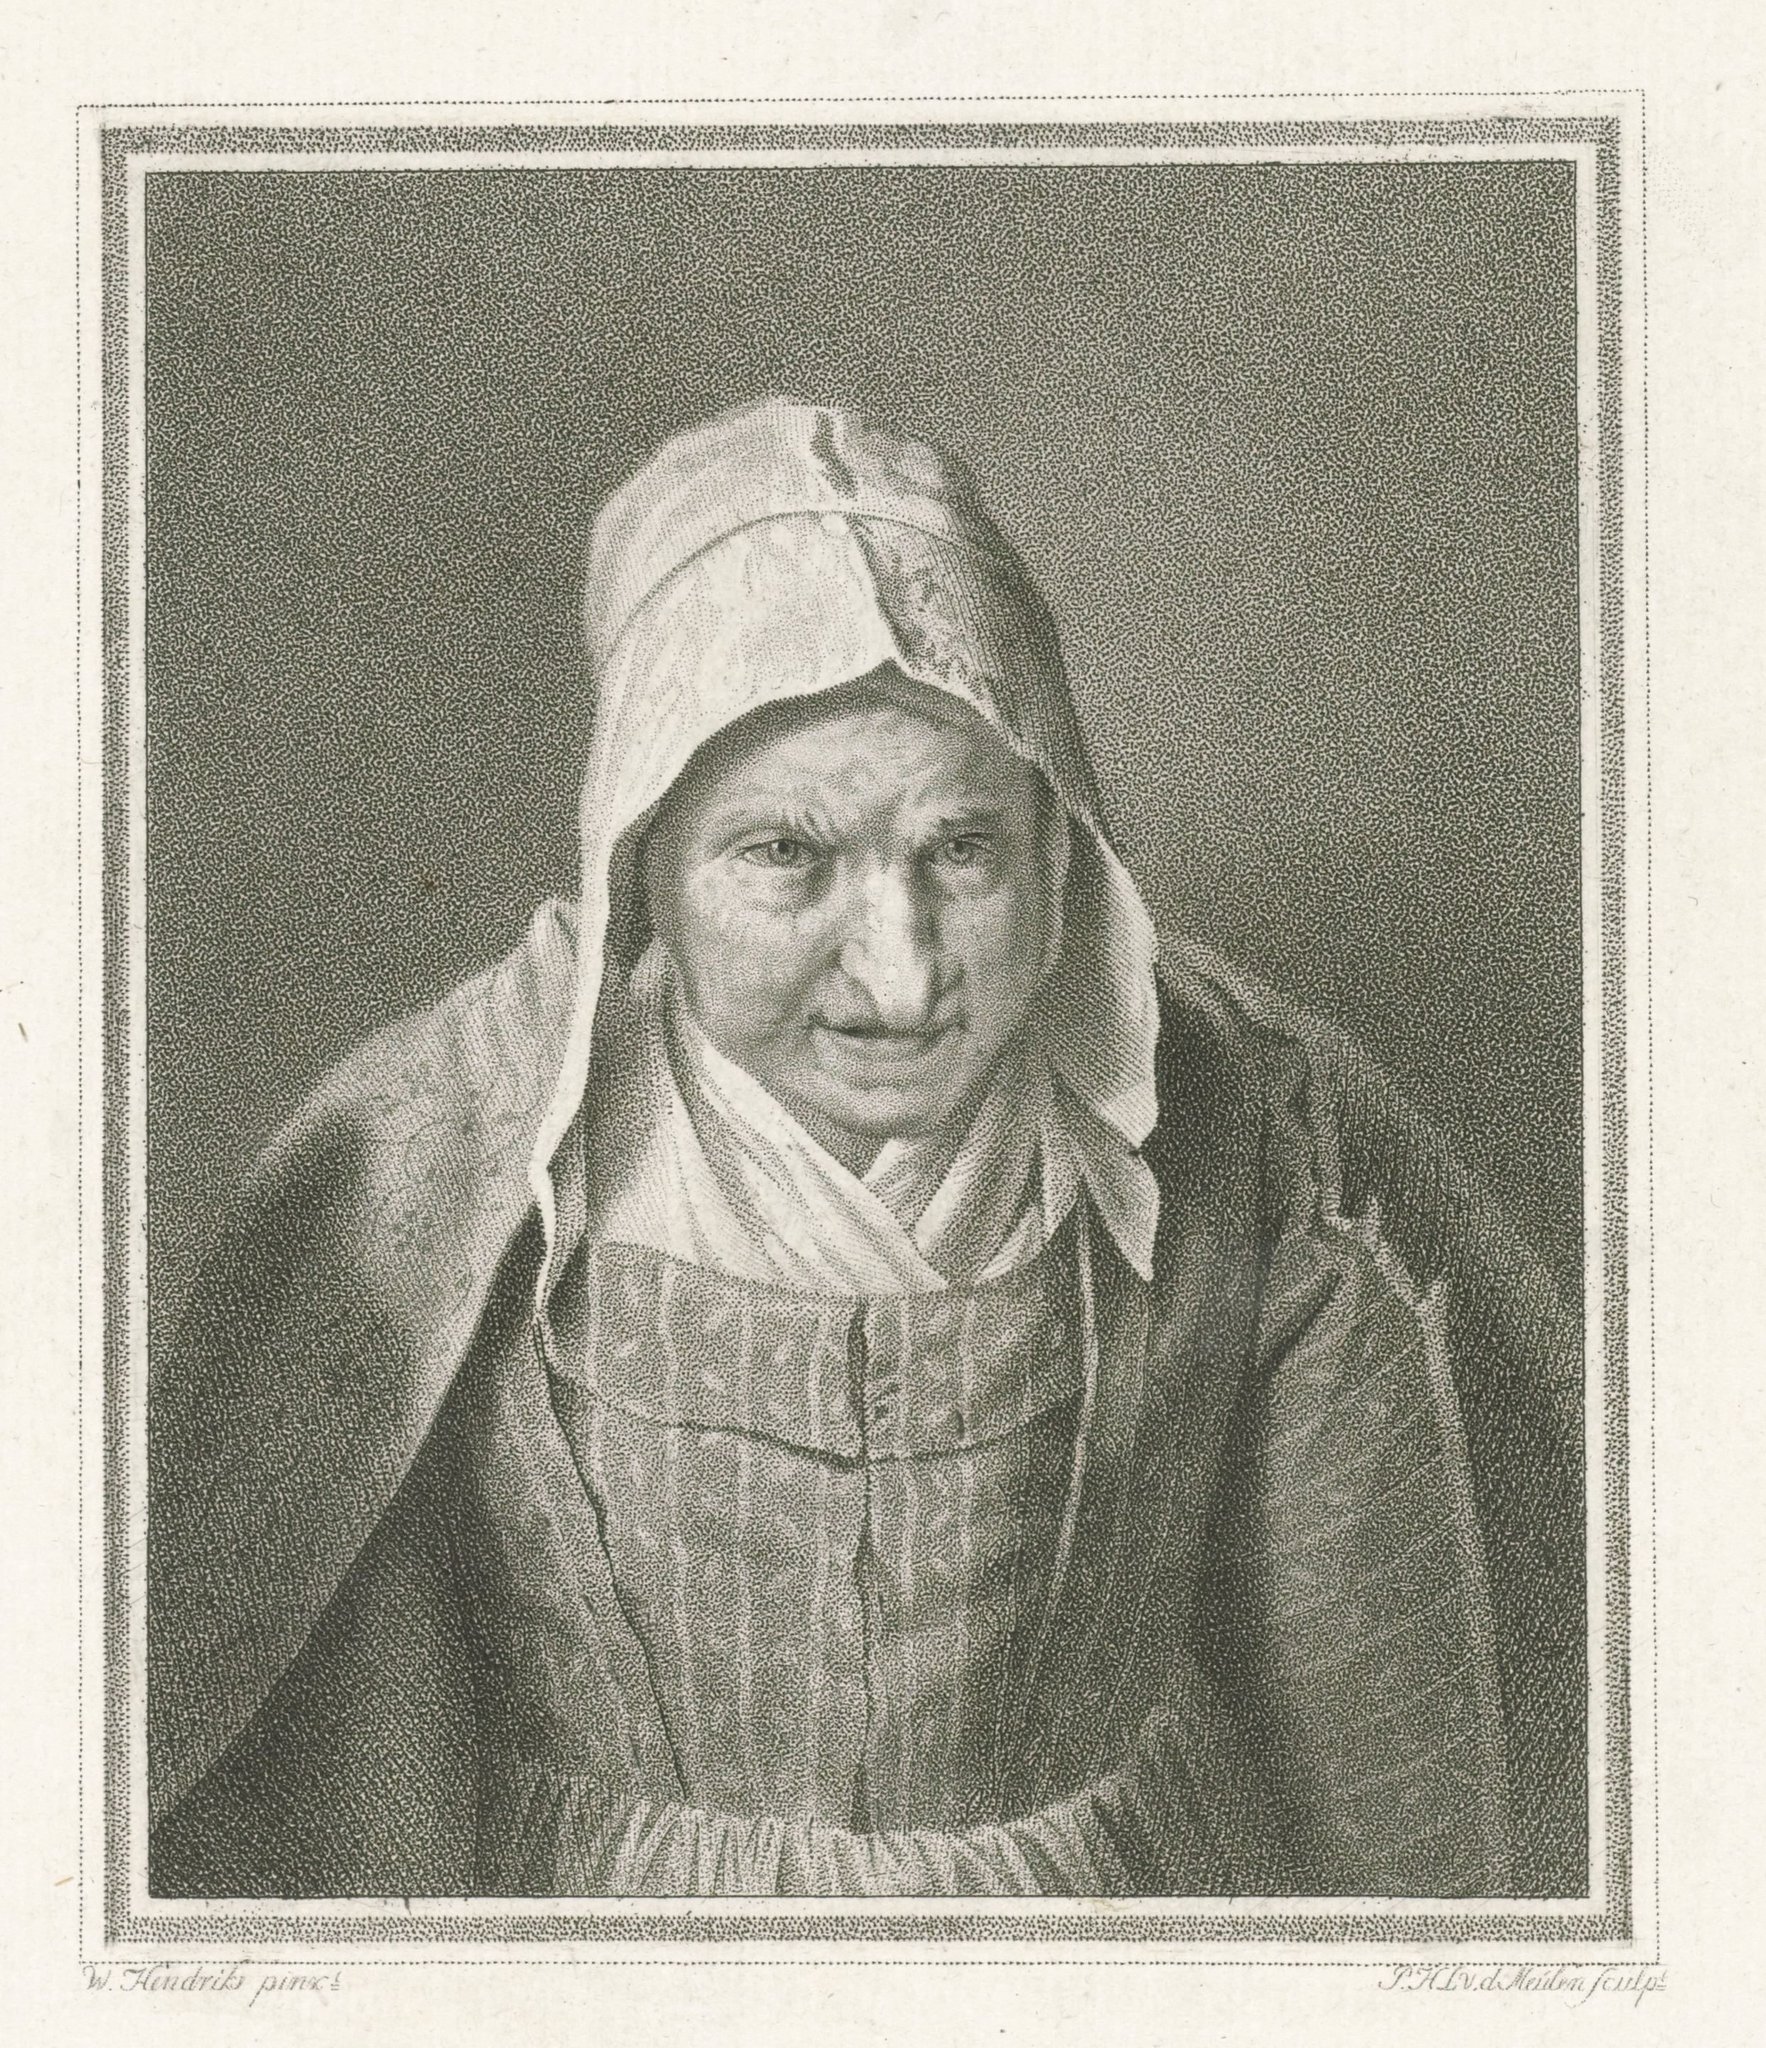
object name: print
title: Portret van Maria Kouwenhoven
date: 1808-1810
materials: paper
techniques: stippled etching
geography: amsterdam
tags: haarlem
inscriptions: number: ‘514’, collector's mark: Lugt 2228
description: Portret van Maria Kouwenhoven op 101-jarige leeftijd.